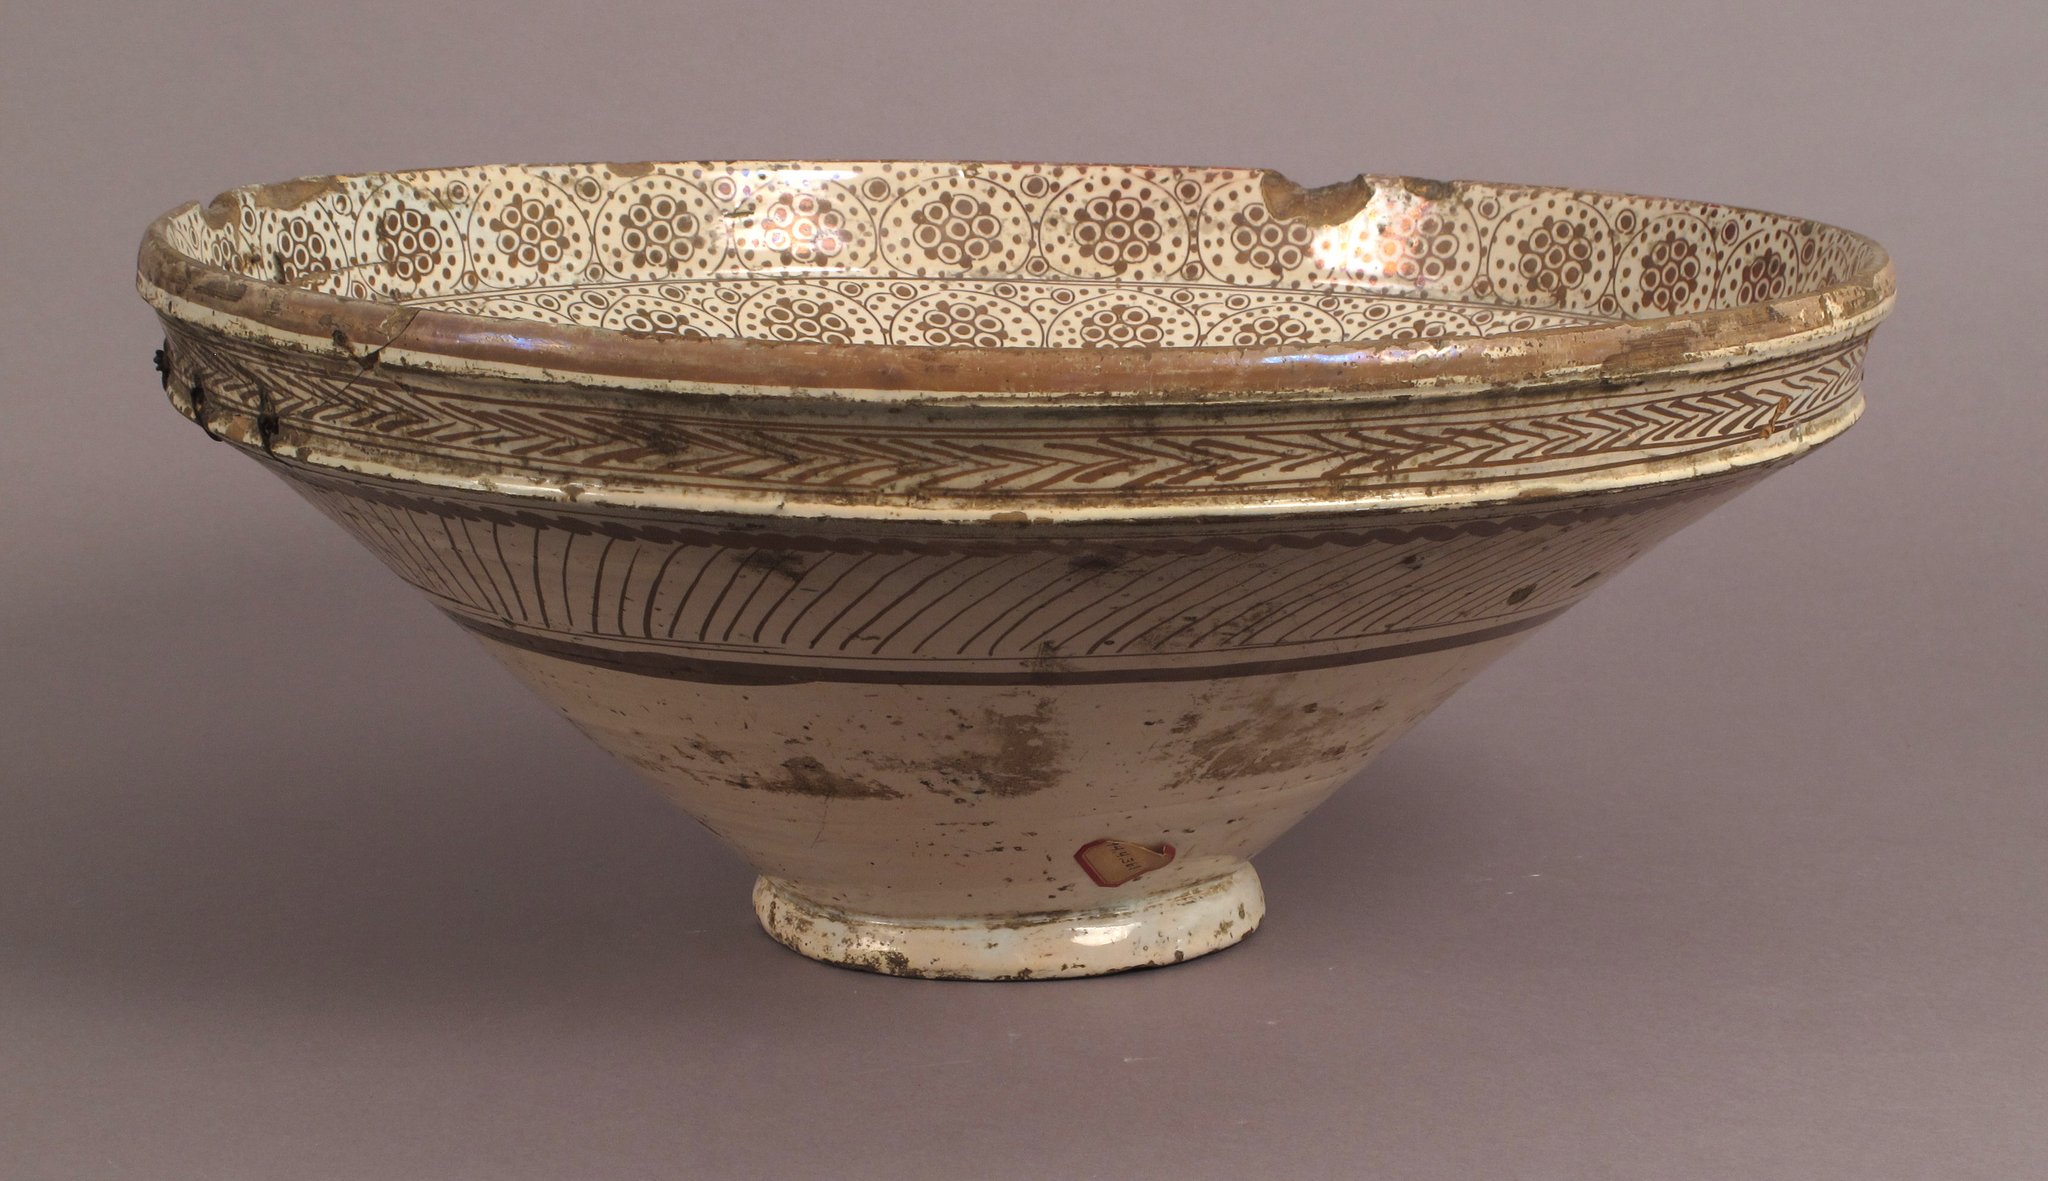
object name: bowl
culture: spanish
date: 1400-1450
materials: earthenware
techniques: glazing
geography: spain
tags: flowers